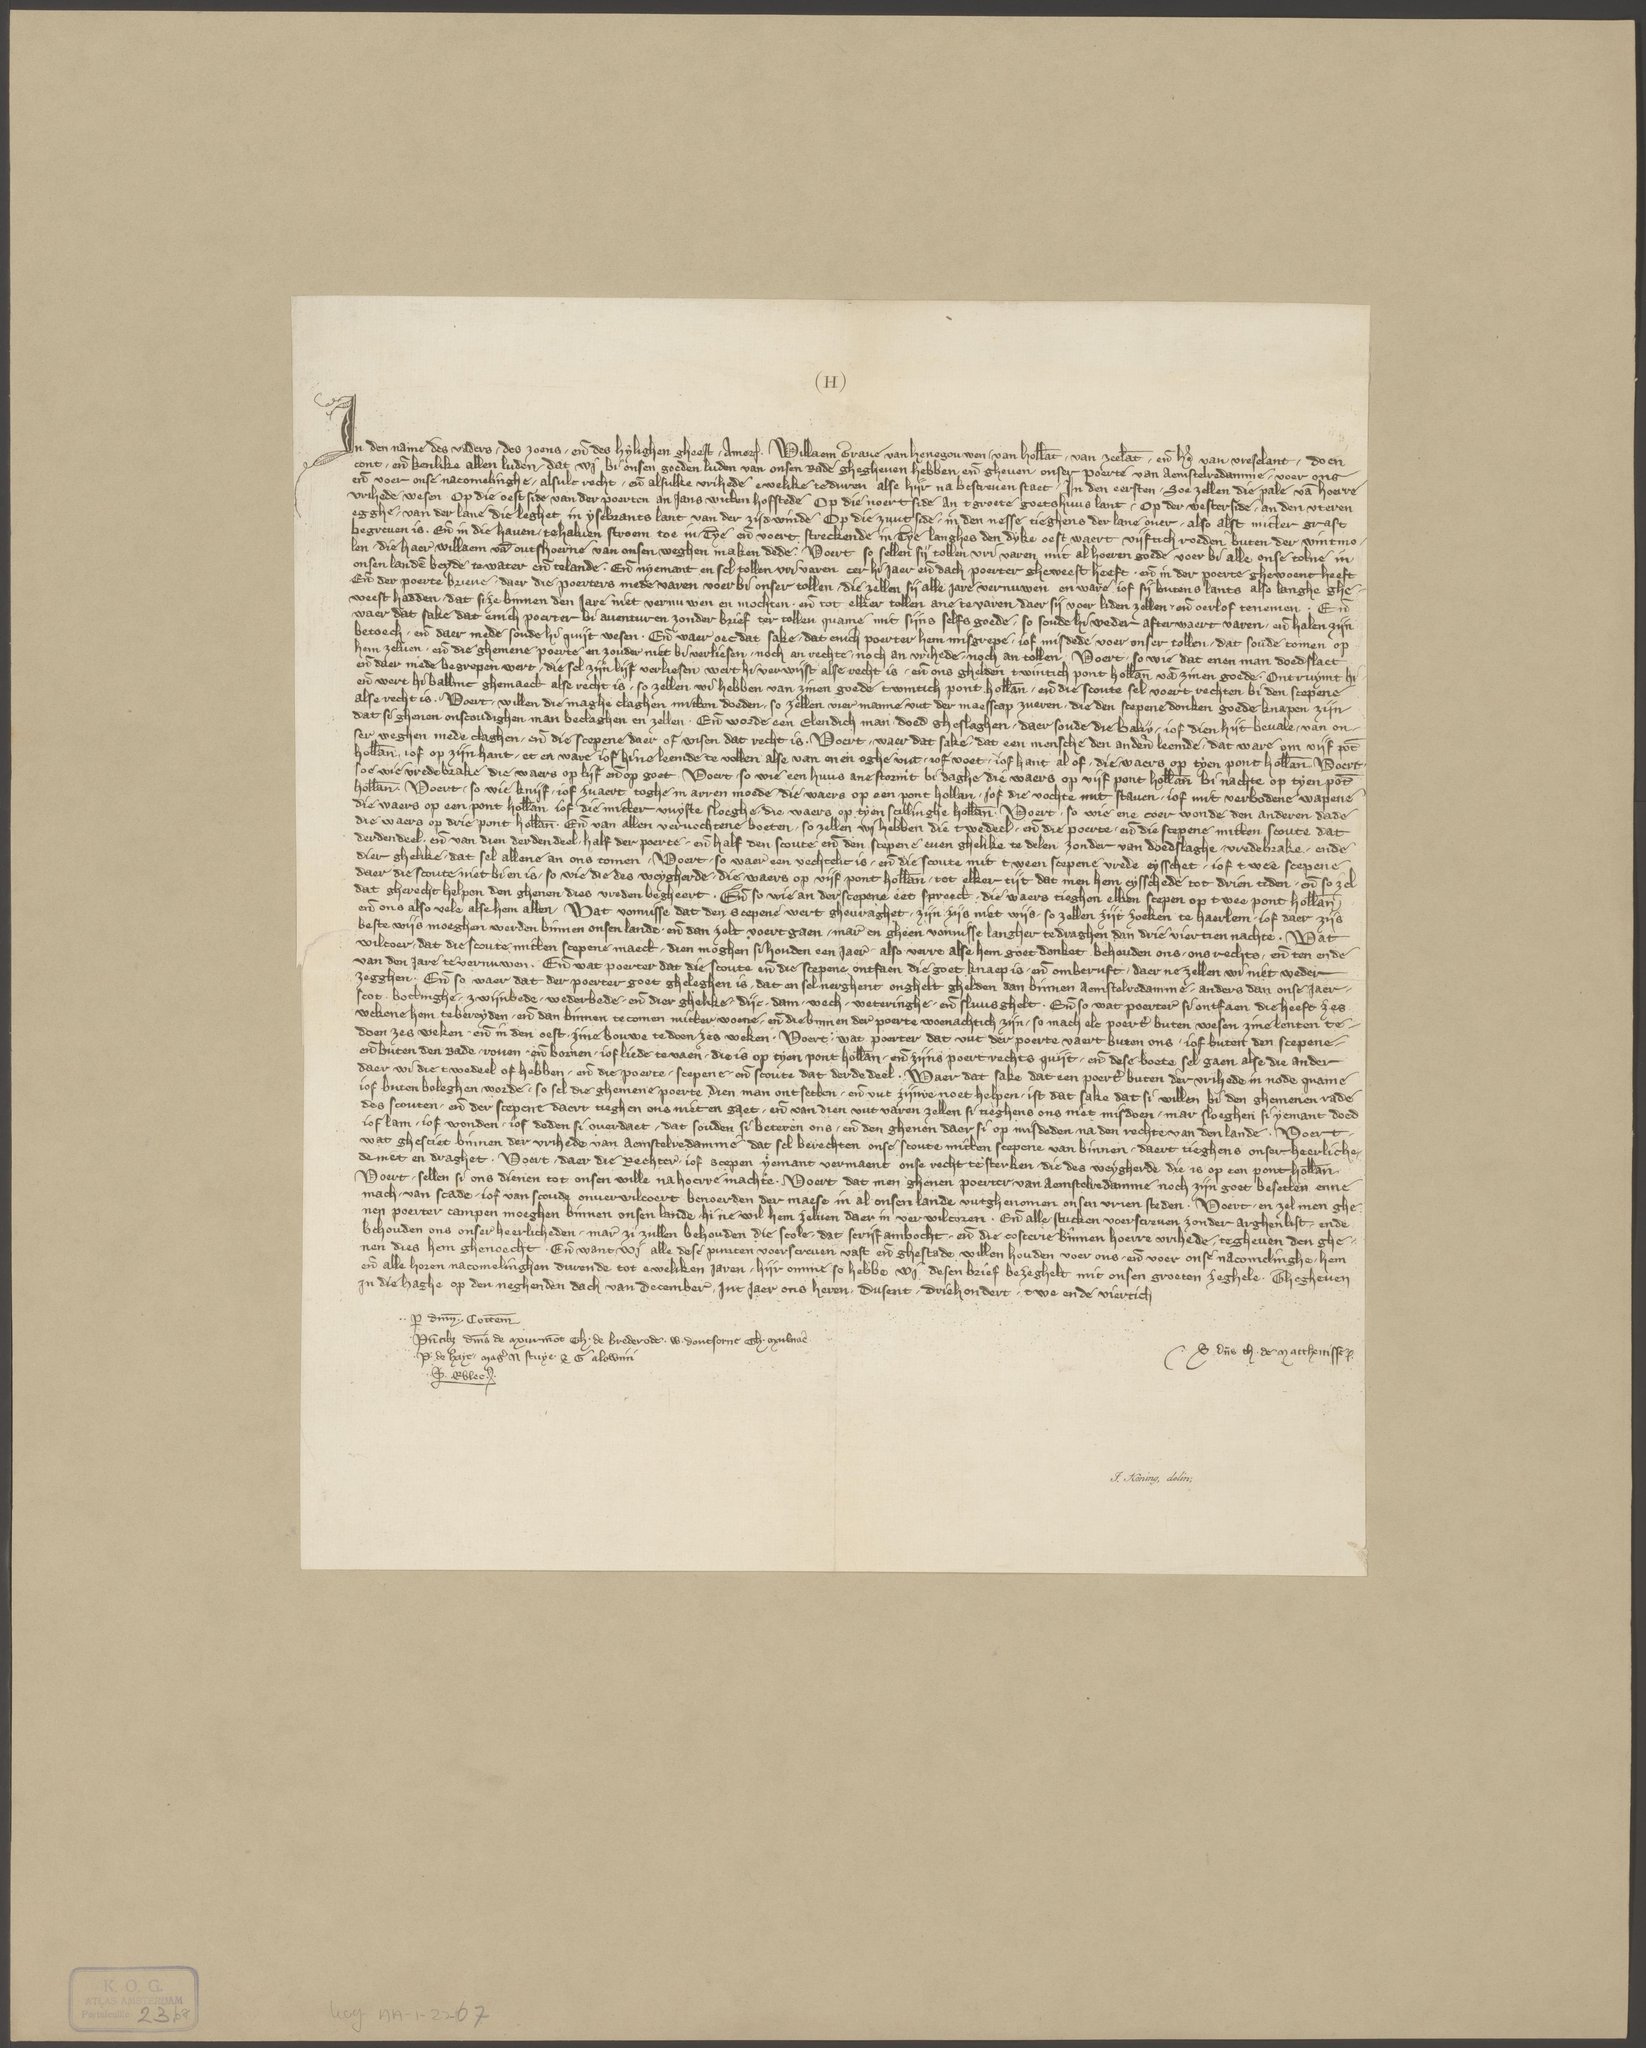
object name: print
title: Privilege van Amsterdam, 1342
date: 1821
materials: paper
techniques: etching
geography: netherlands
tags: willem iv (graaf van holland), ruler conferring privileges, amsterdam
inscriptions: collector's mark: Lugt 1641b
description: Prent waarschijnlijk uit: Verhandelingen der Tweede Klasse van het Koninklijk-Nederlandsche Instituut van Wetenschappen, Letterkunden, en Schoone Kunsten te Amsterdam, dl. 2. Amsterdam: Pieper & Ipenbuur, 1821. Of uit: De merkwaardigste stukken uit de oudste archieven van Amsterdam, aangaande de vroegere privilegiën, van deszelfs poorters en inwoners. Amsterdam: Pieper & Ipenbuur, 1821.